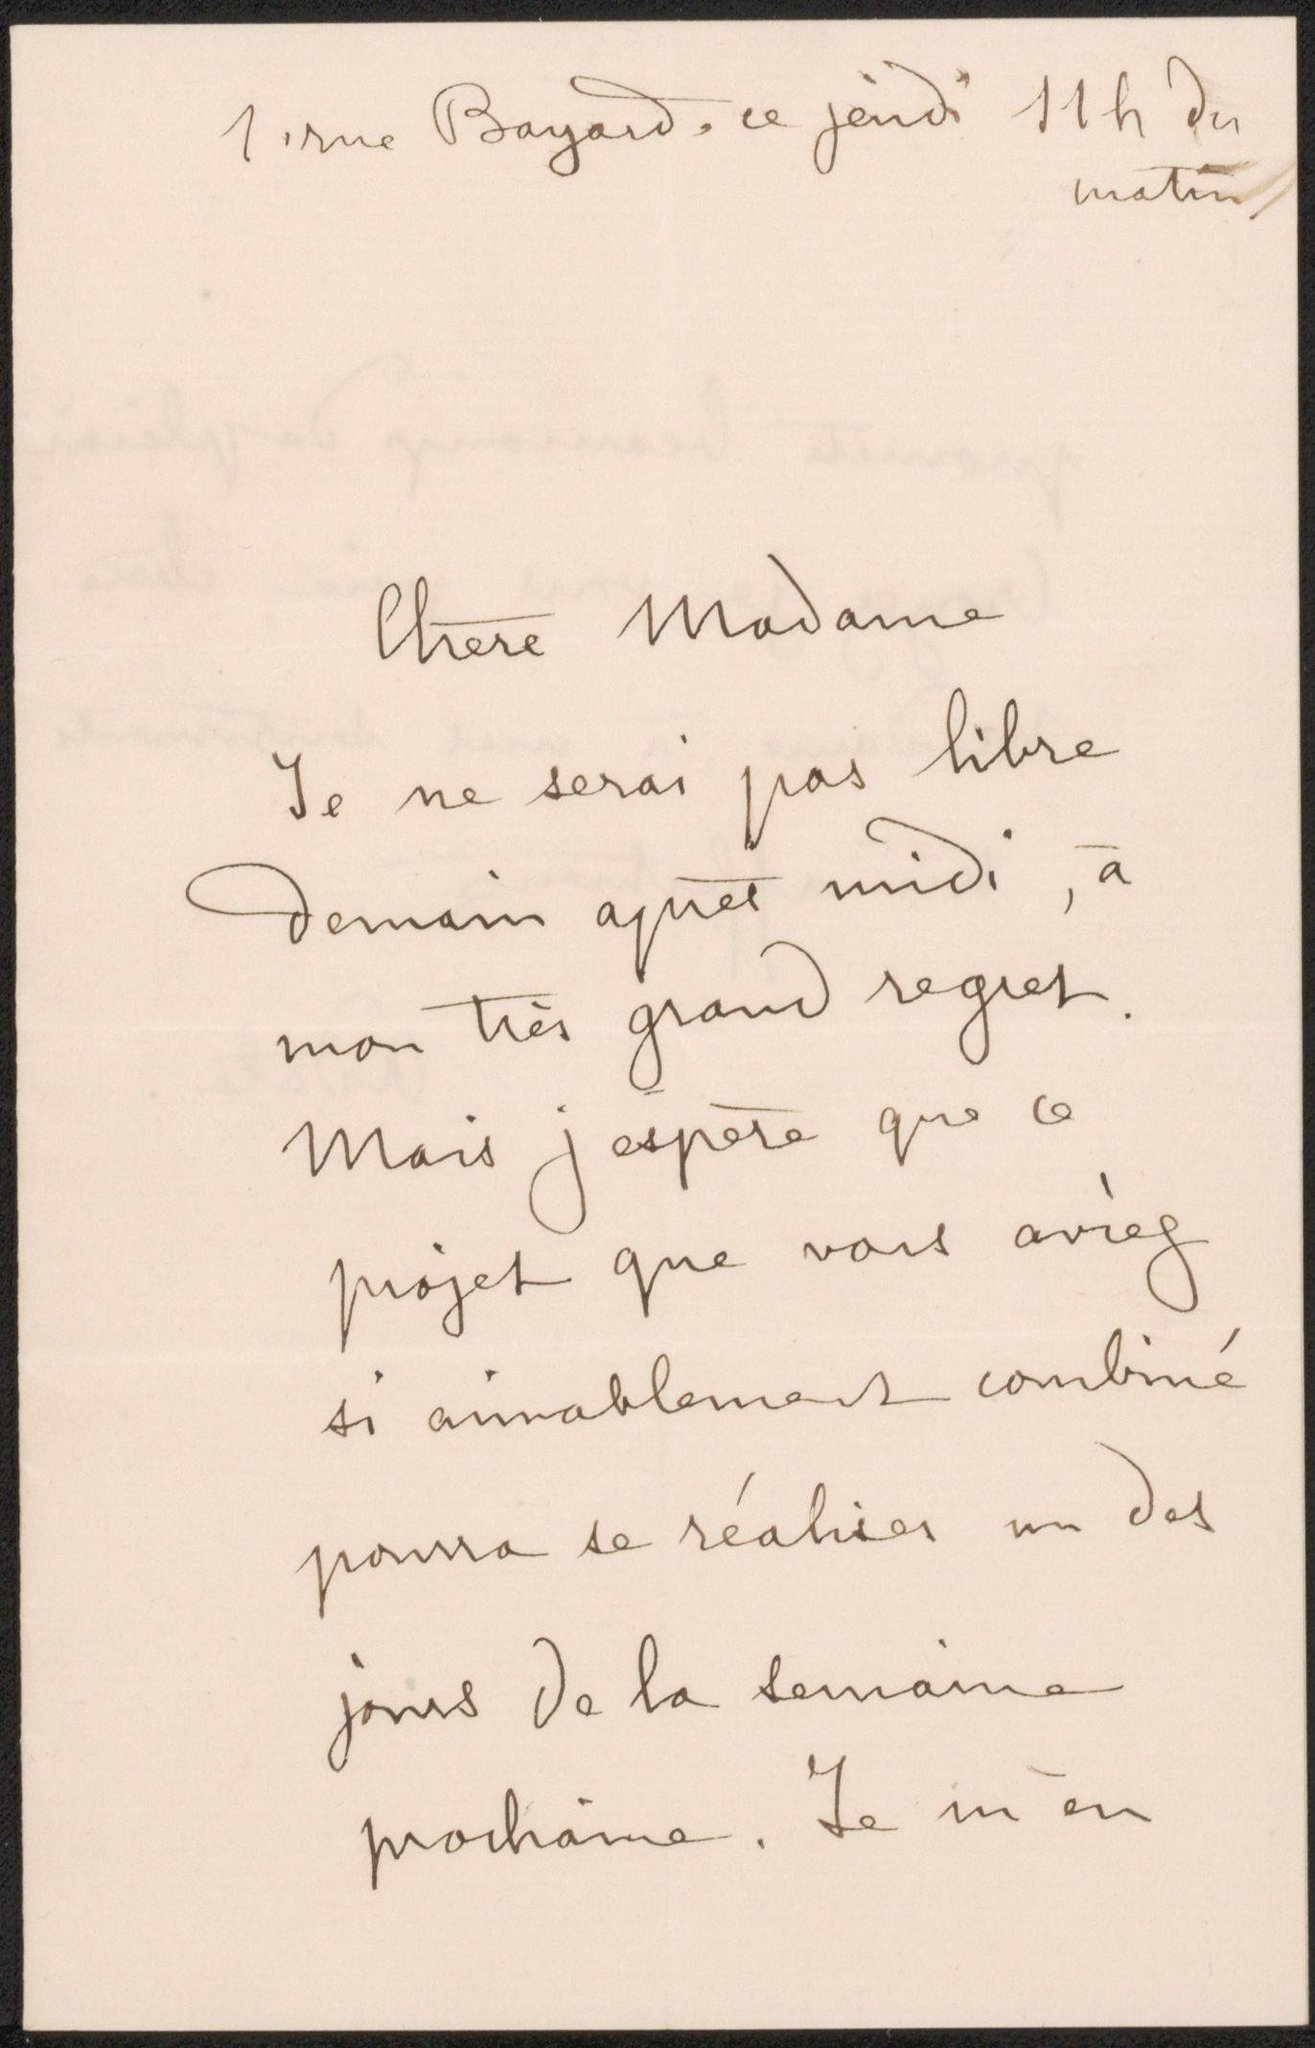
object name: letter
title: Brief aan anoniem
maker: adèle d affry (hertogin van colonna di castiglione)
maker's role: sculptor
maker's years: 1836-1879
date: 1846-1879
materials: ink, paper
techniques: pen, writing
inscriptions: collector's mark: Lugt 2228, watermark